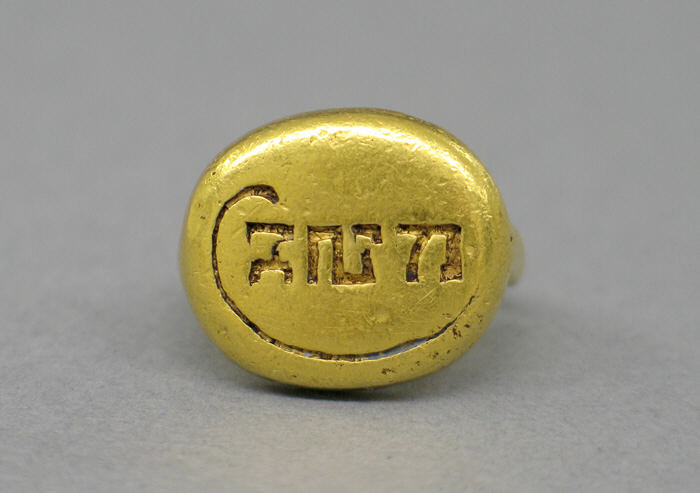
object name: ring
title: Ring with Plain Oval Bezel and "Java Kuno" Inscription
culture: indonesian, javanese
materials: gold